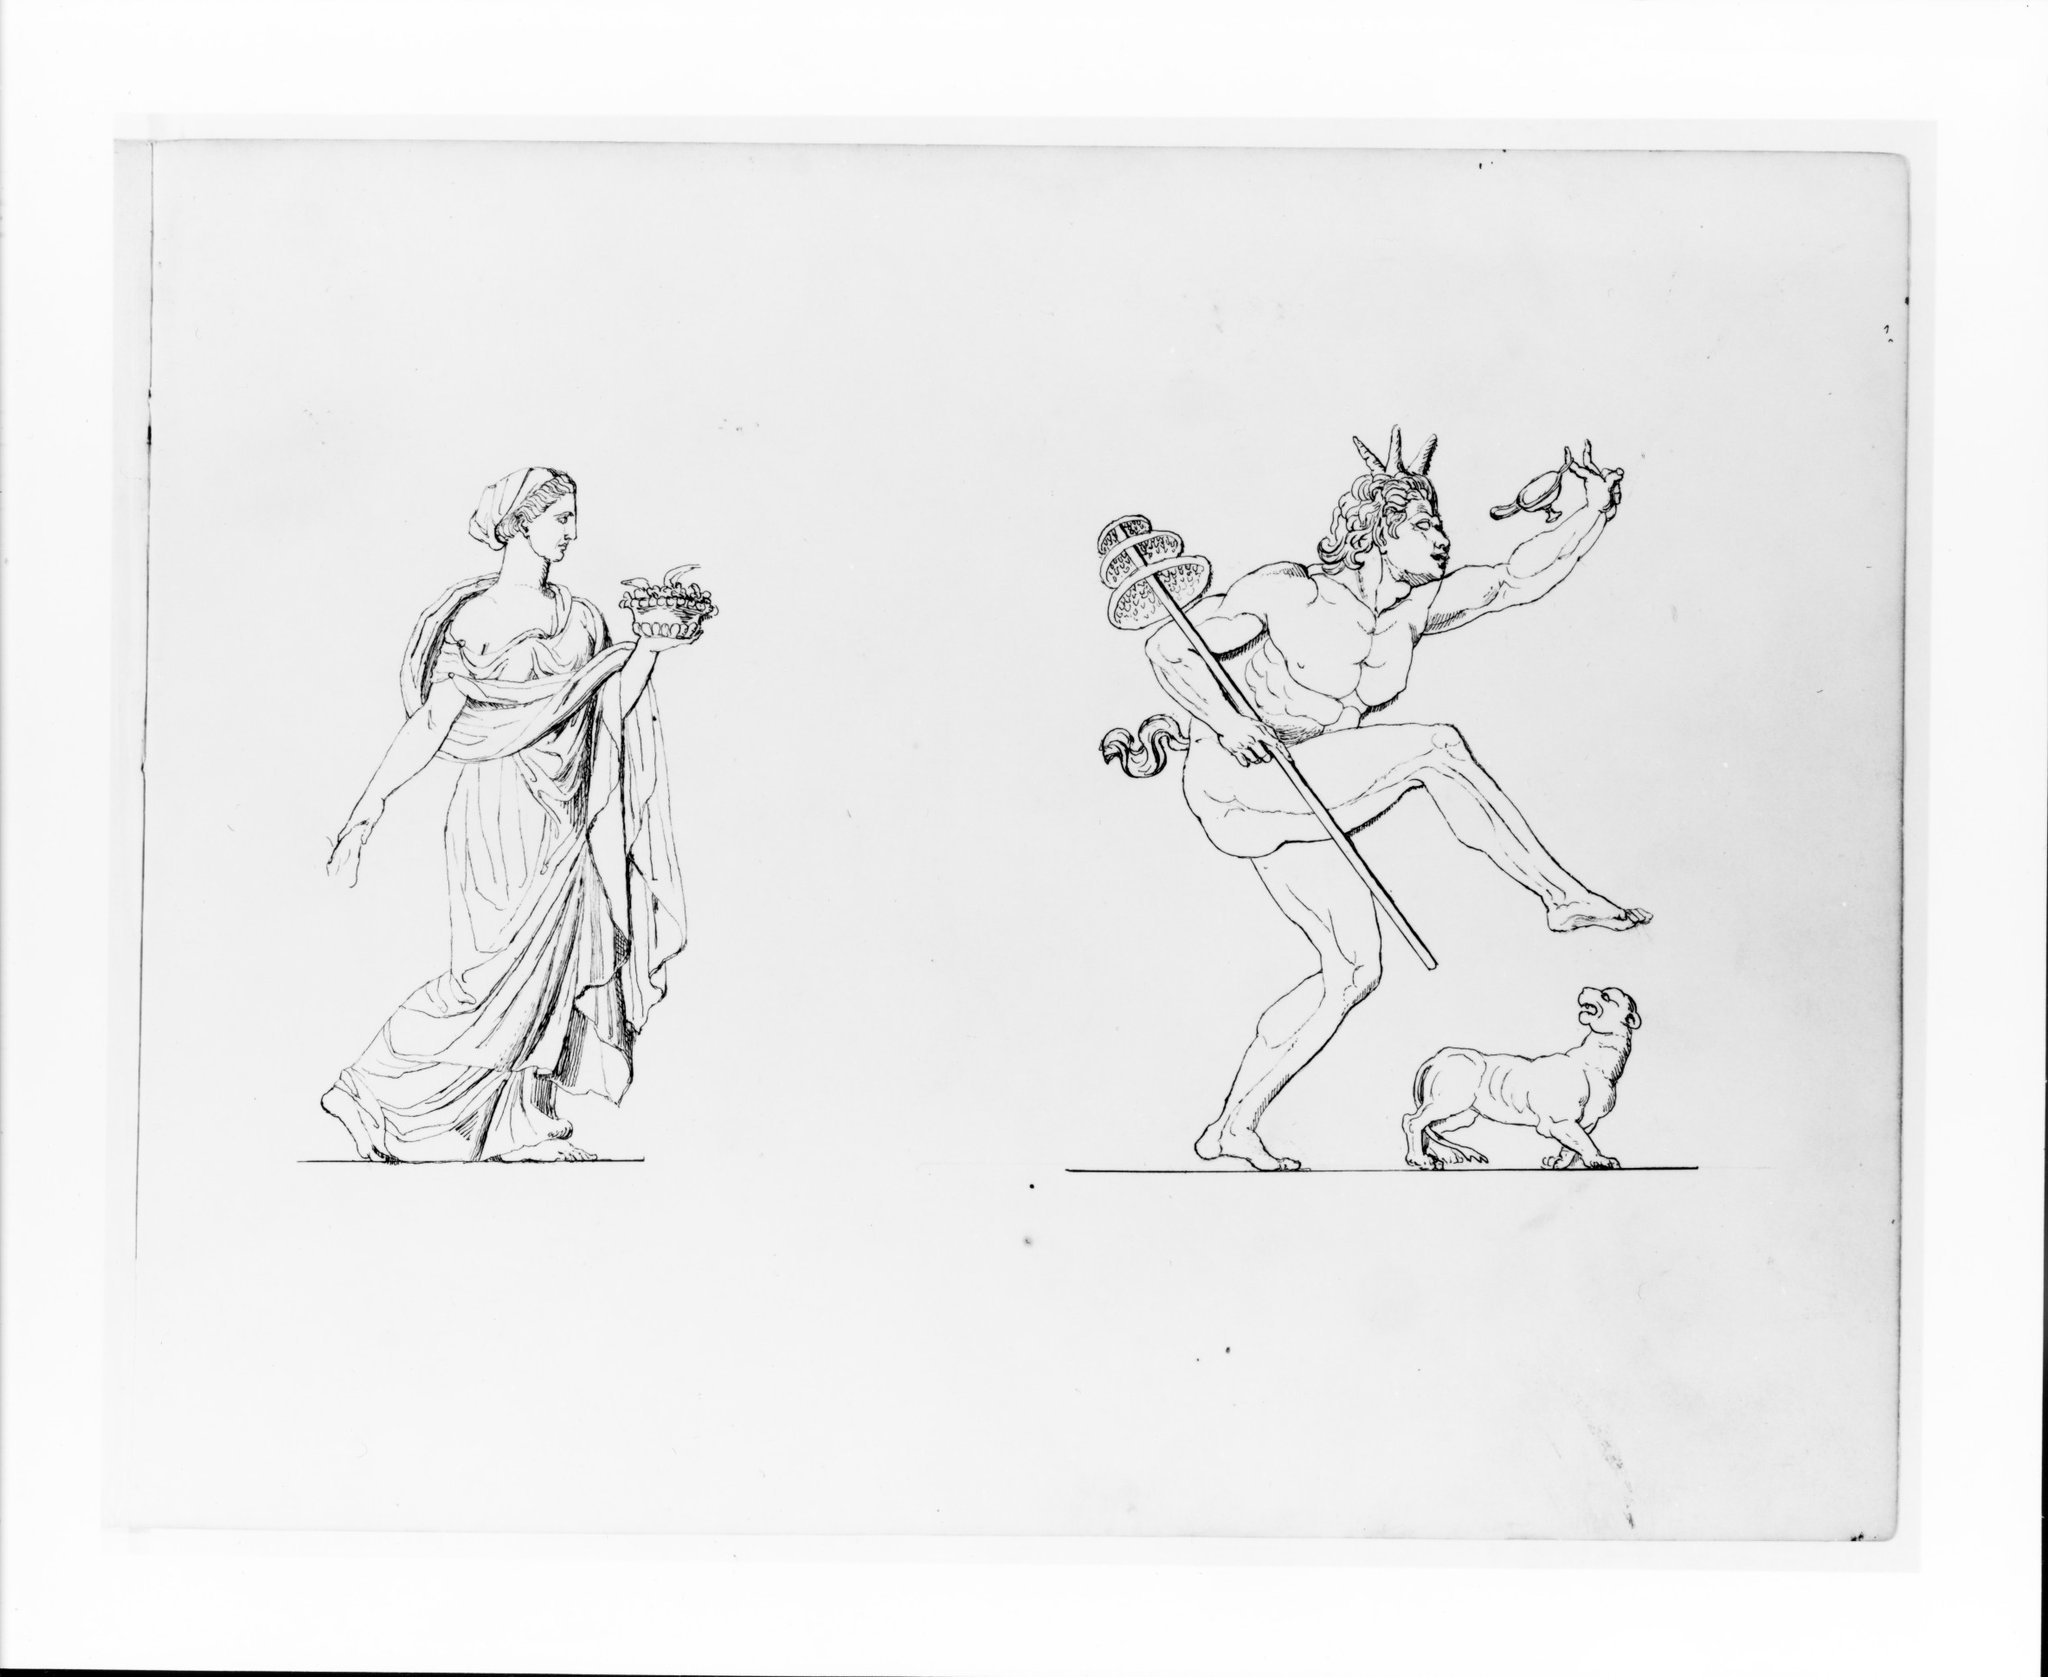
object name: drawing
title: Classical Female Figure; Satyr and Dog (from Sketchbook)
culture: american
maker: john quincy adams ward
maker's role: artist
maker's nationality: american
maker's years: 1830-1910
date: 1860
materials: ink, paper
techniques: pen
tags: women,satyrs,dogs